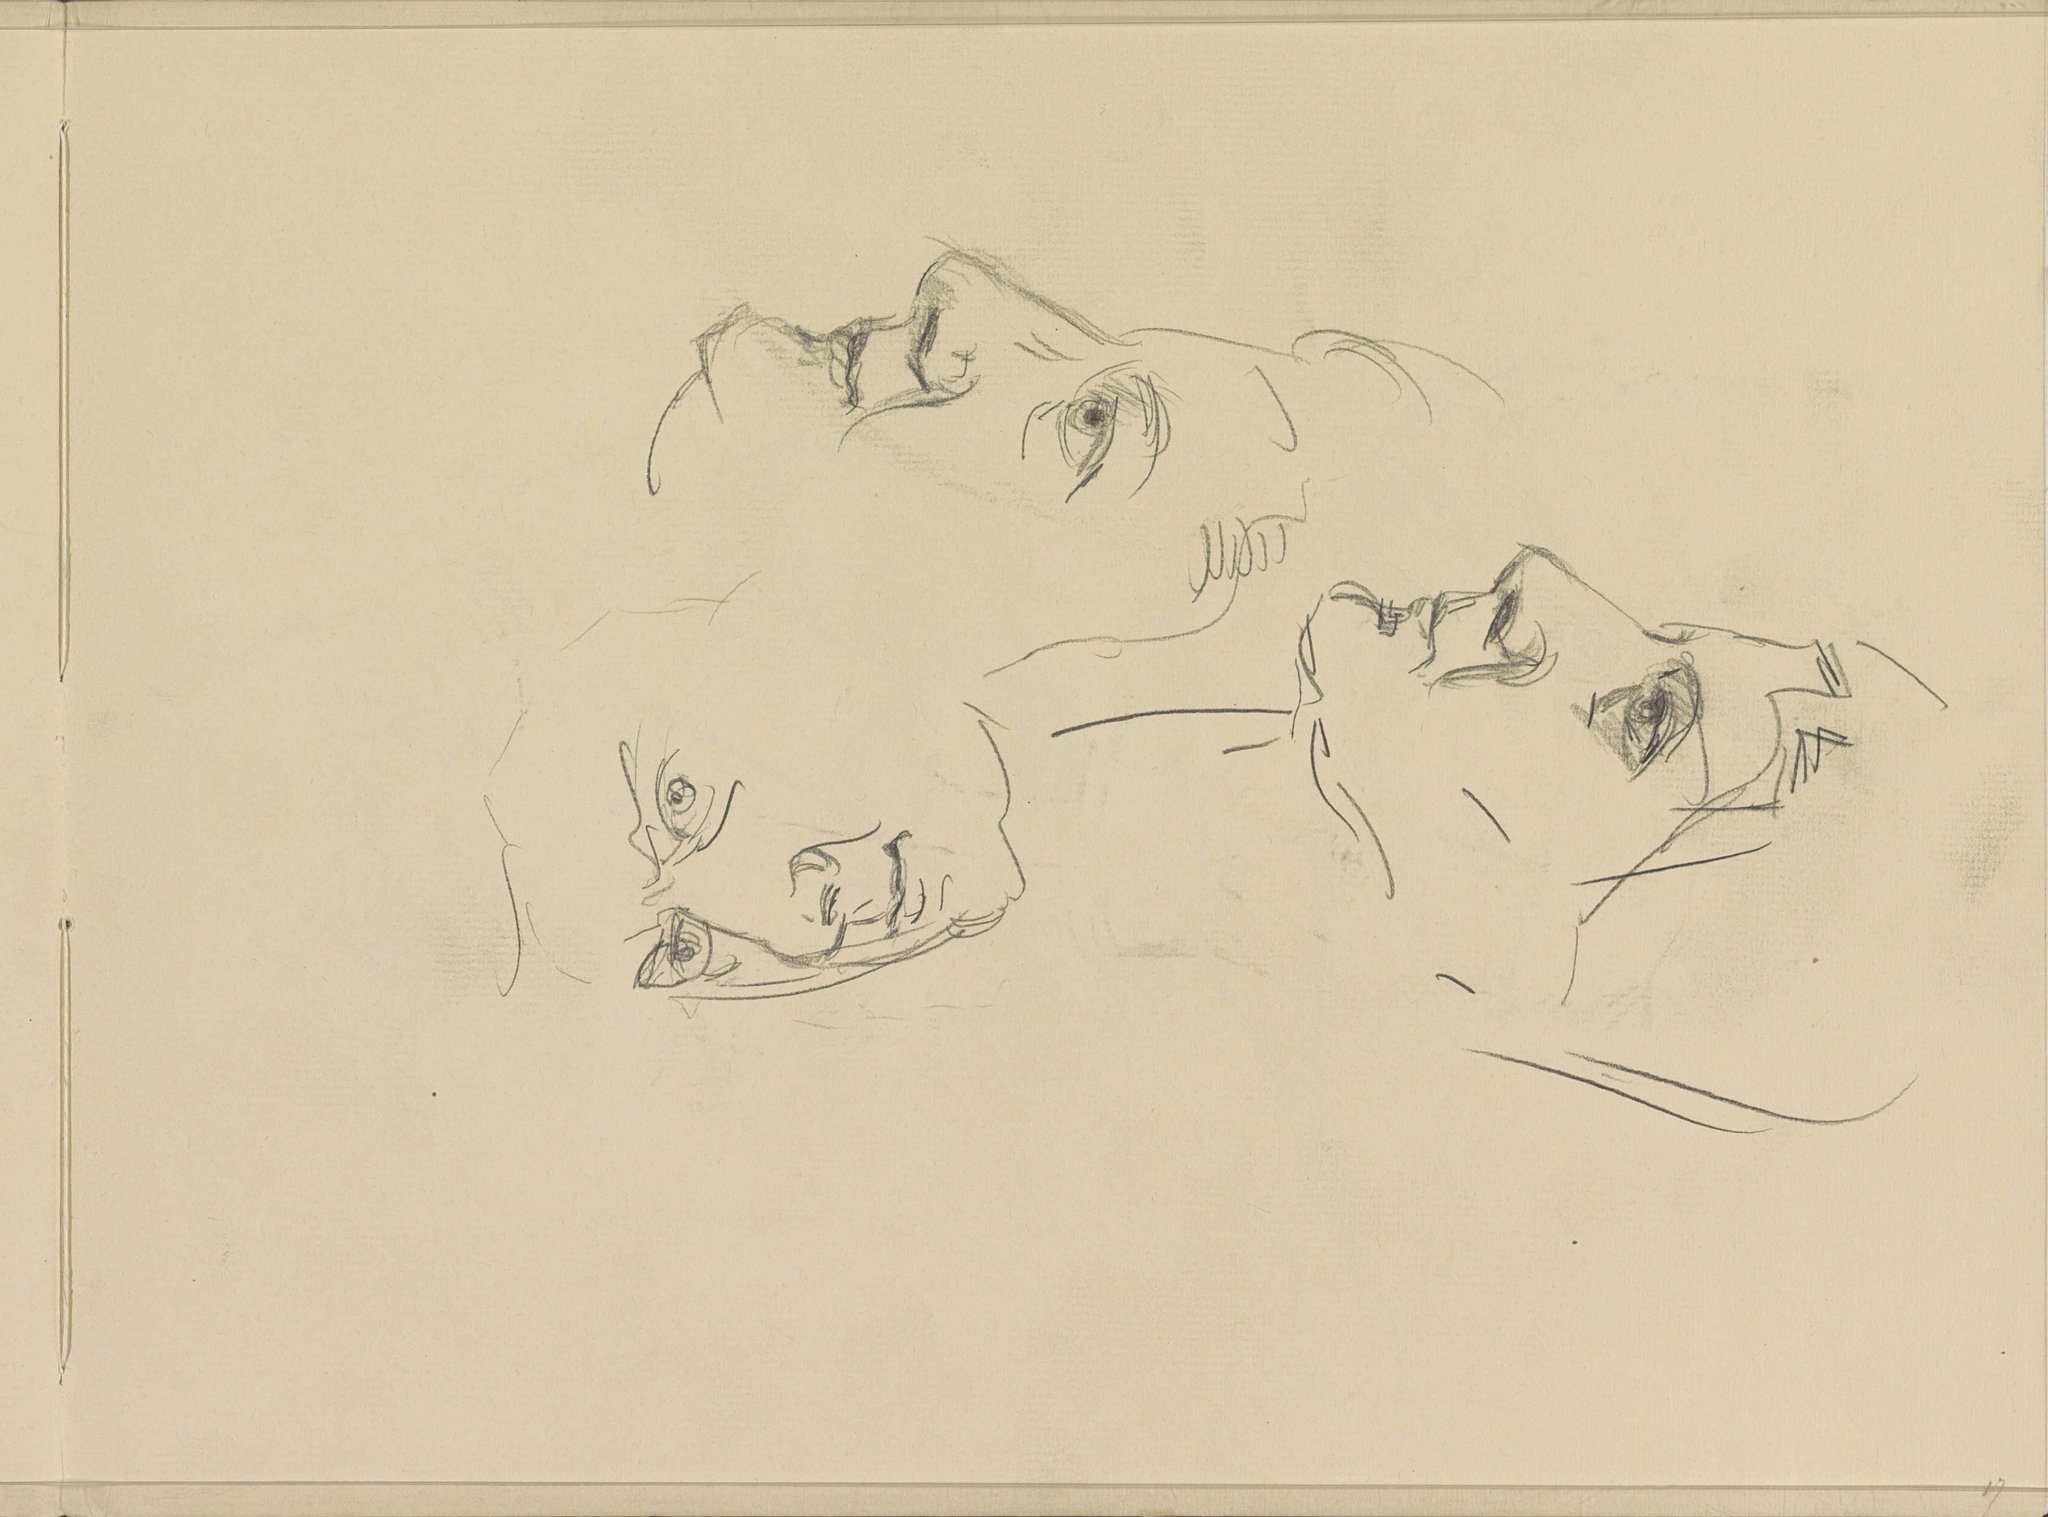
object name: sketchbook leaf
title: Studieblad met gezichten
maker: isaac israels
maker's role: draughtsman, painter, print maker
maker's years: 1865-1934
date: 1875-1934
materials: paper, pencil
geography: the hague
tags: face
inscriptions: watermark: ‘Ingres’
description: Blad 17 recto uit schetsboek IV met 27 bladen.